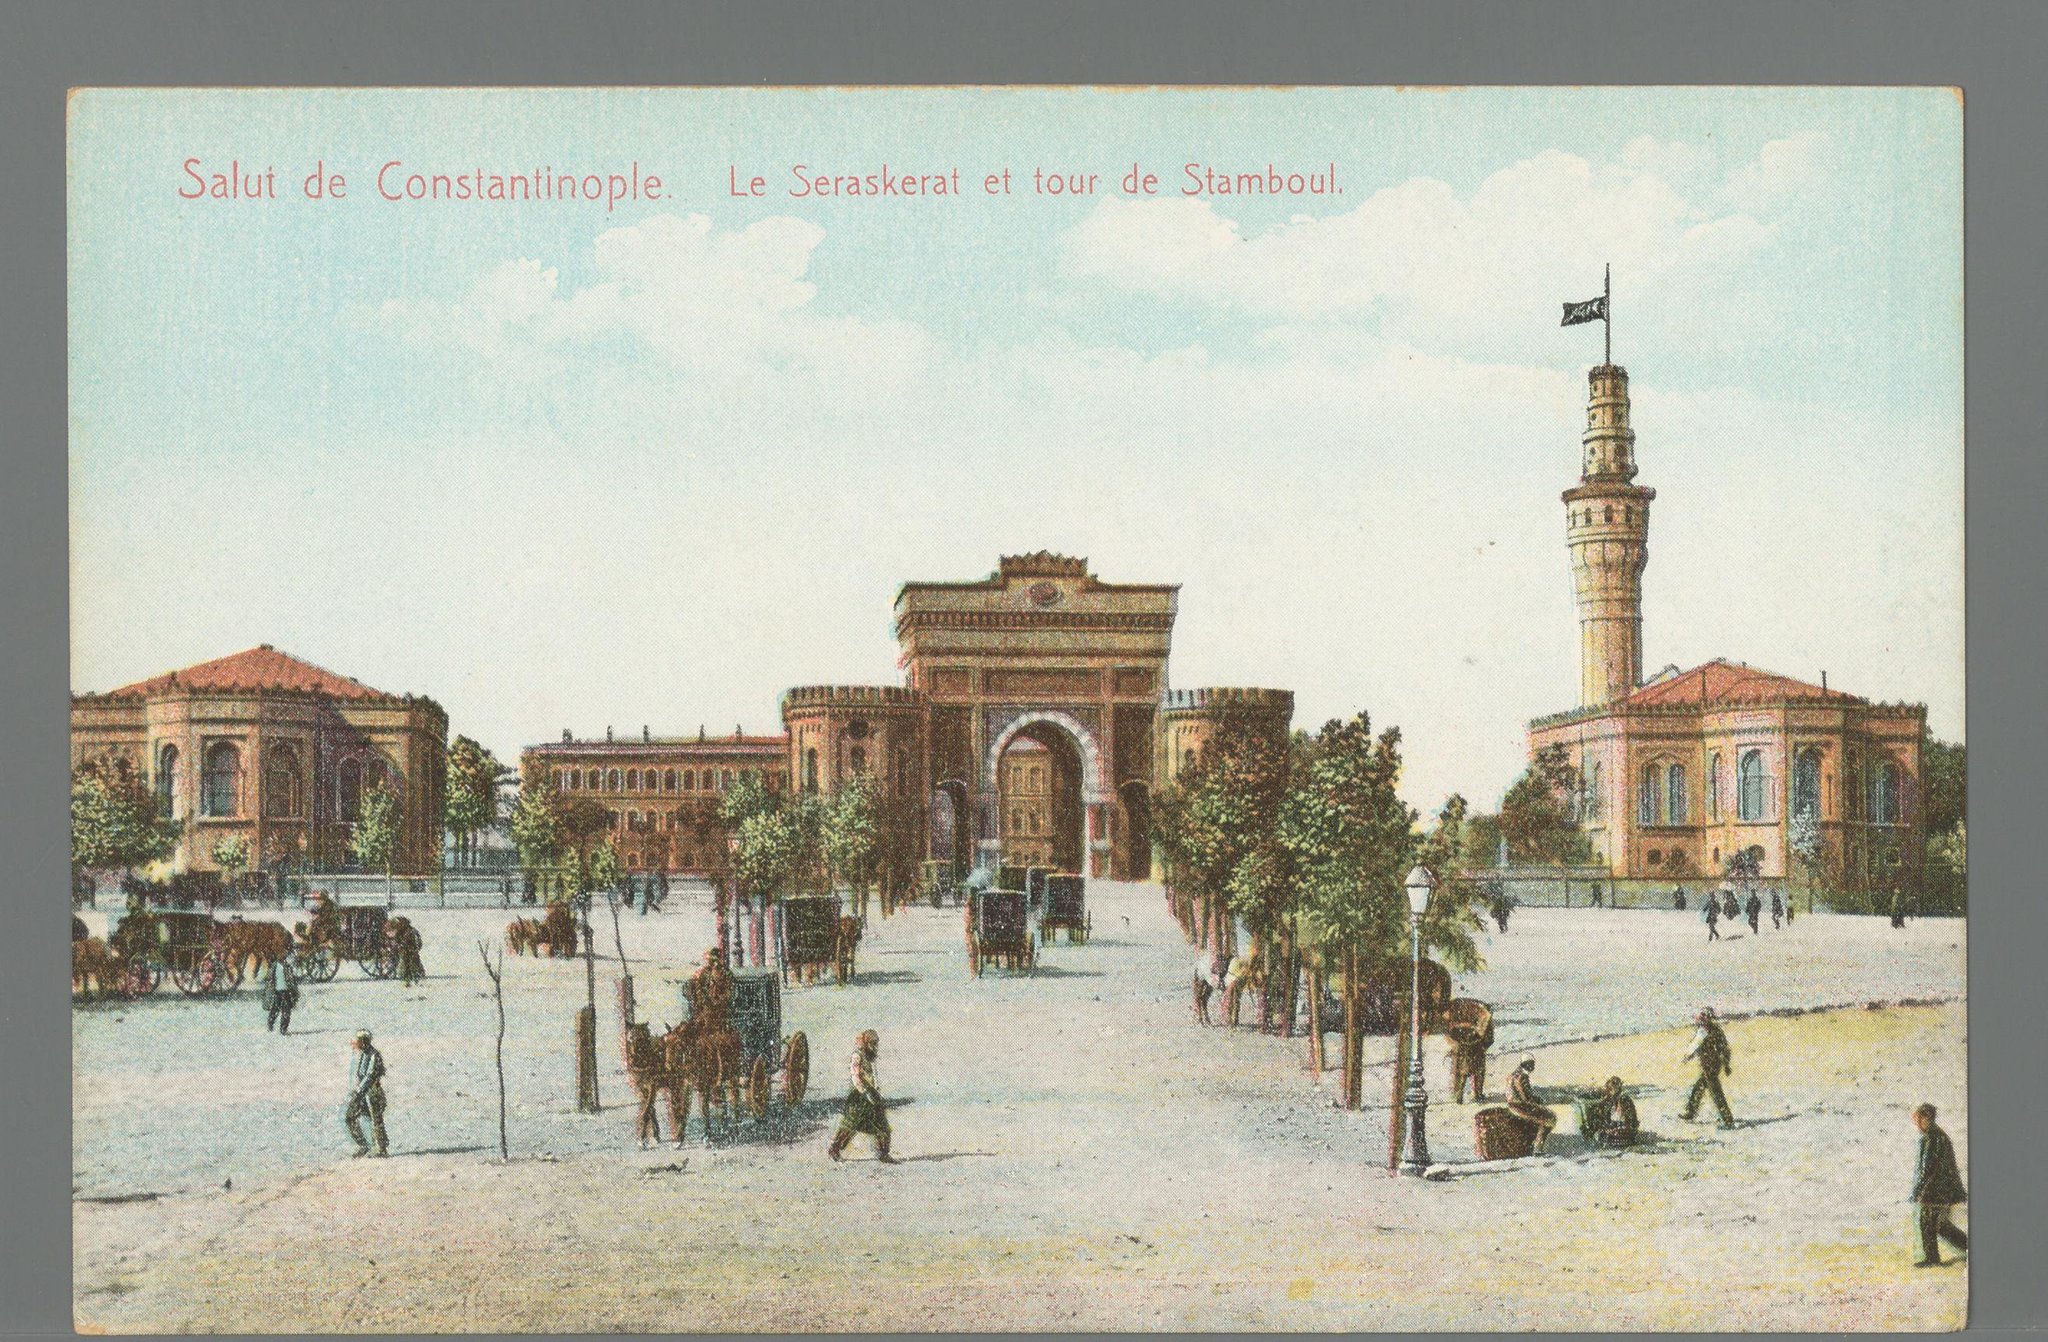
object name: photomechanical print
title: Le Seraskerat et tour de Stamboul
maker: Anonymous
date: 1906-1920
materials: cardboard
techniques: lithograph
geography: constantinople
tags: administrative bodies, square, place, circus, etc. (+ city(-scape) with figures, staffage), tower, clock tower ~ monumental adornment (+ city(-scape) with figures, staffage)